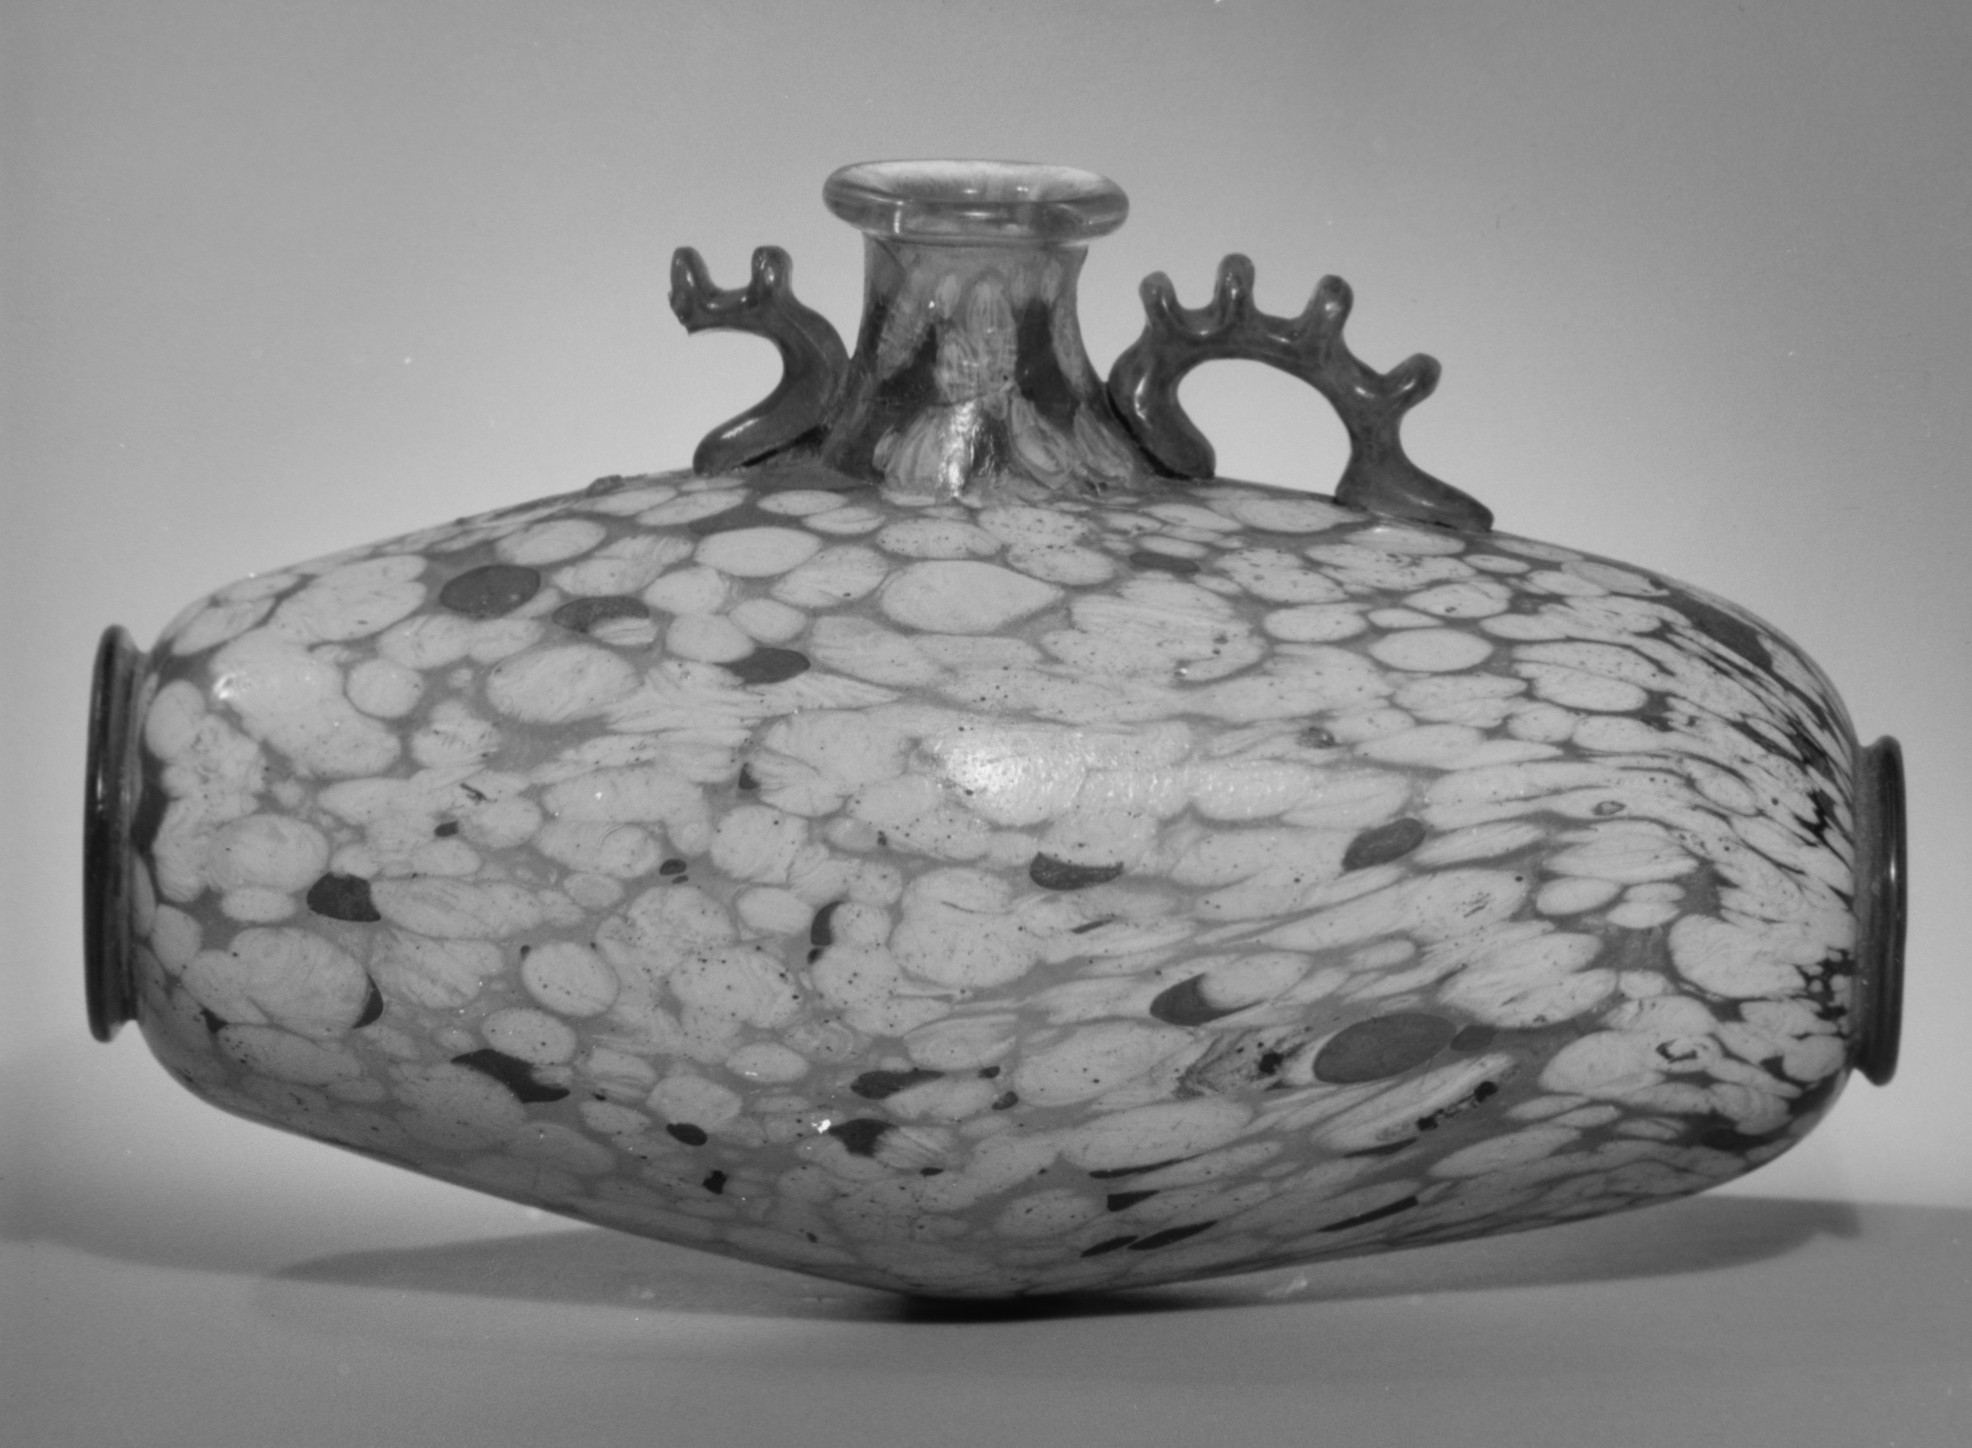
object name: flask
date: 1601-1700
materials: glass